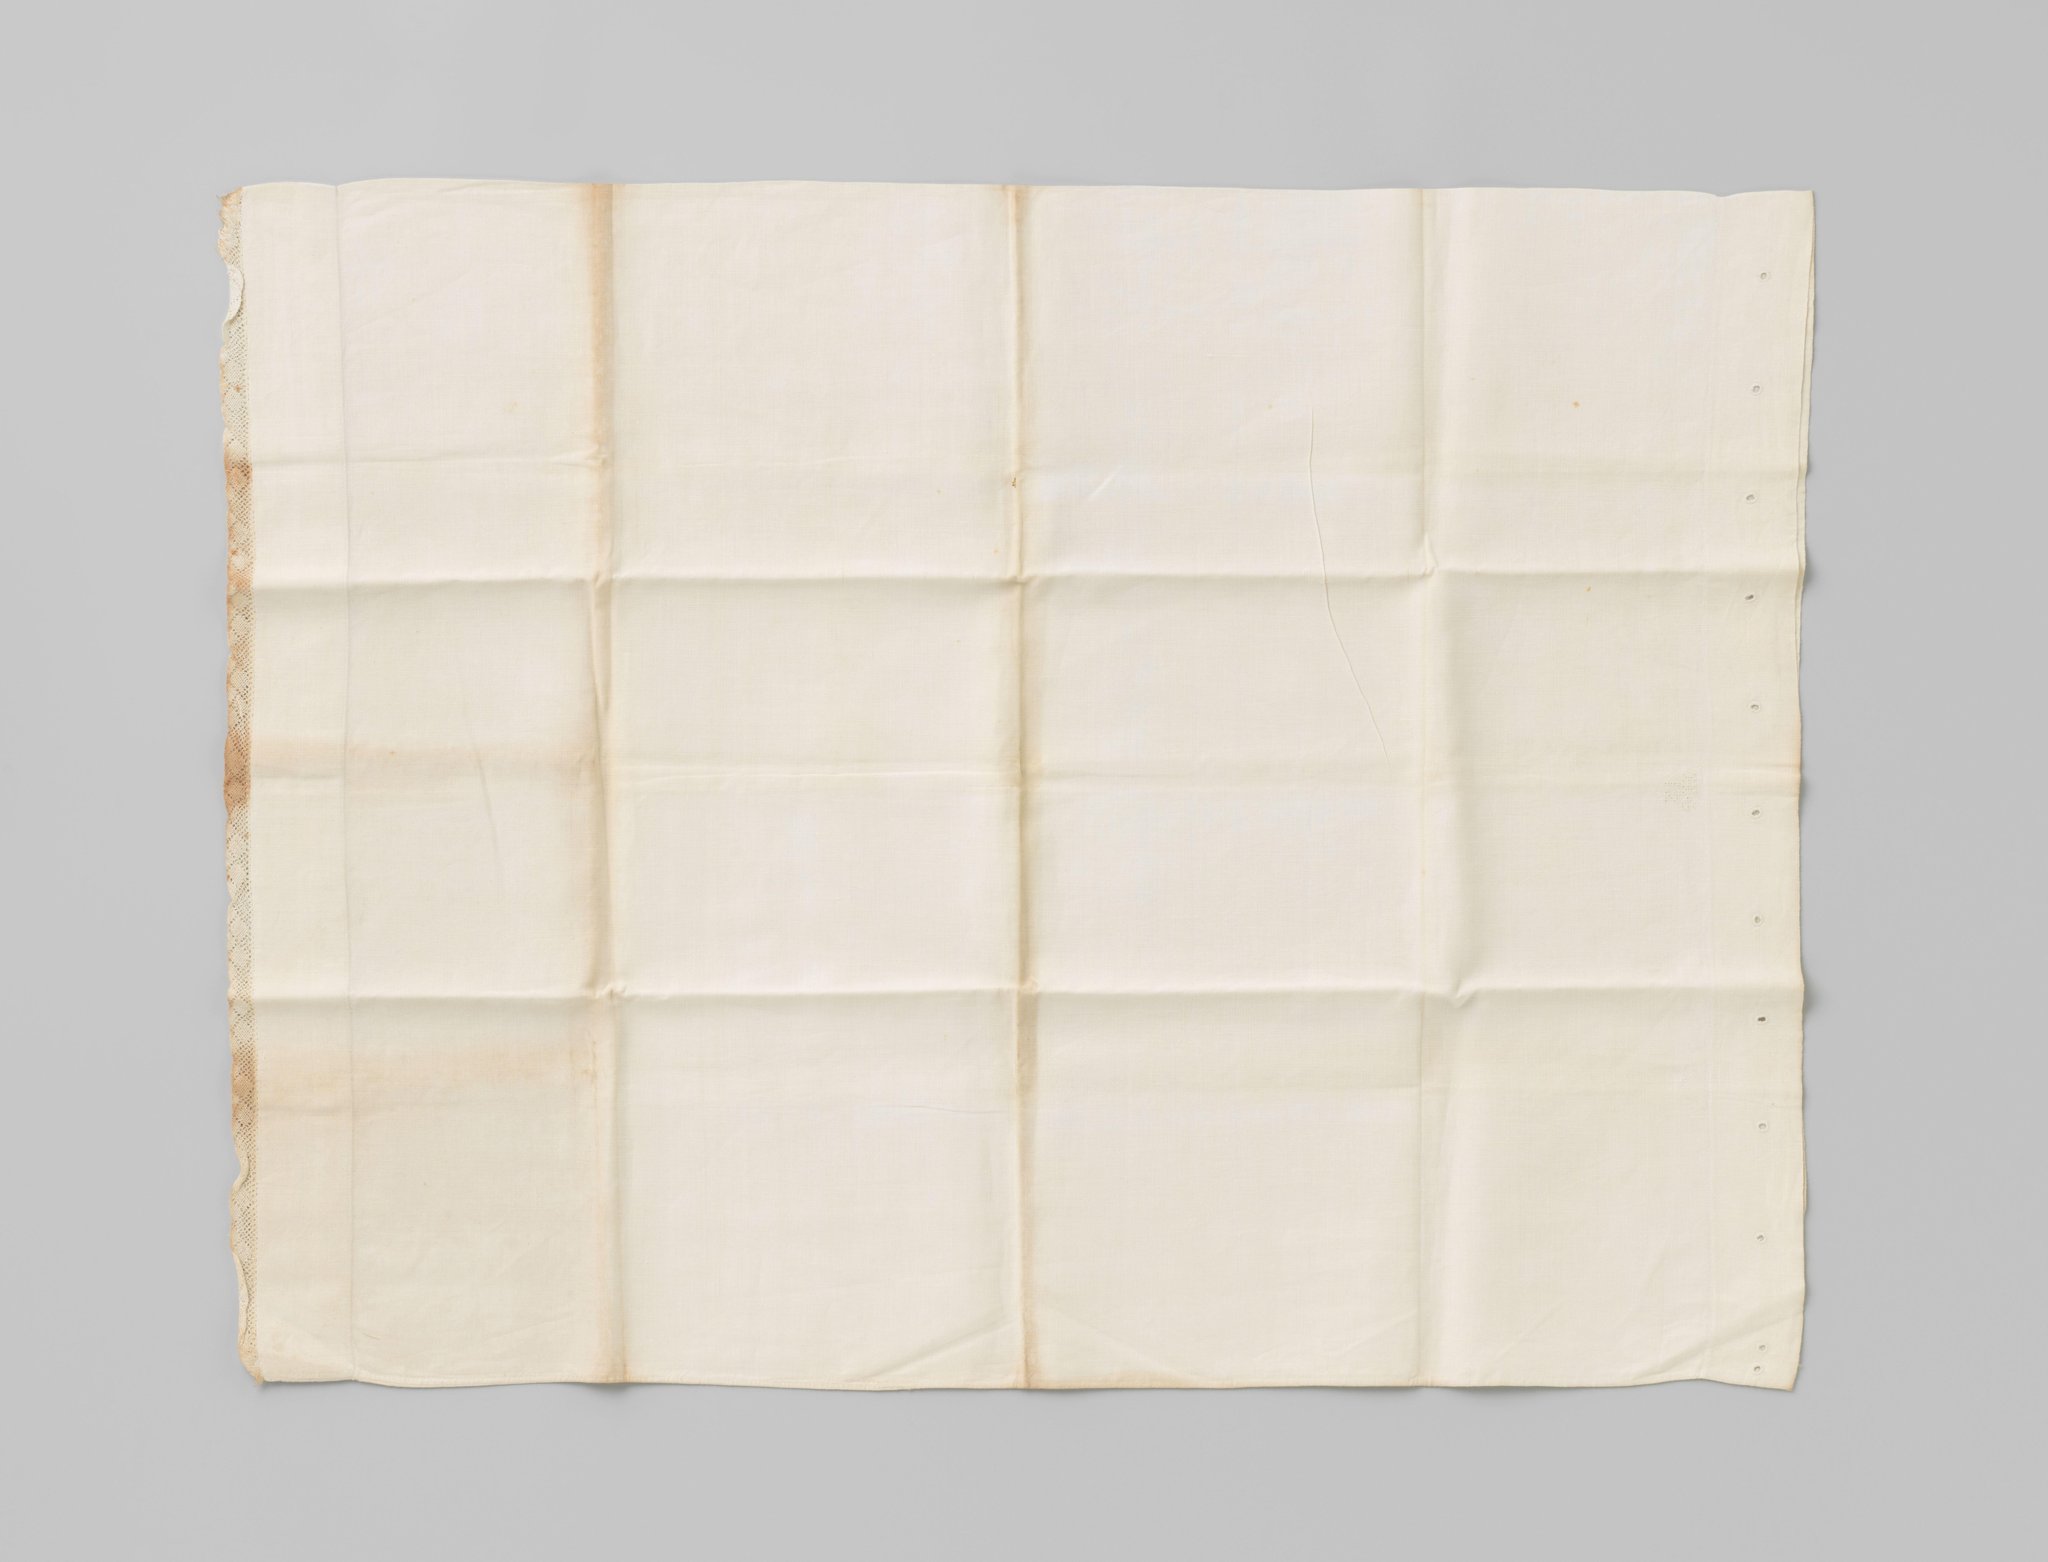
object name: sloop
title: Sloop van linnen met entre-deux van kloskant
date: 1400-1950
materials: linen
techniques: lace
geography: netherlands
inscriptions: mark: ‘HG 12’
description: Sloop van linnen met entre-deux van kloskant met ruitpatroon. Gemerkt H.G.12 in bindgat in het midden van de korte zijde. Met later vernieuwde machinale zomen en gaten voor koordsluiting.